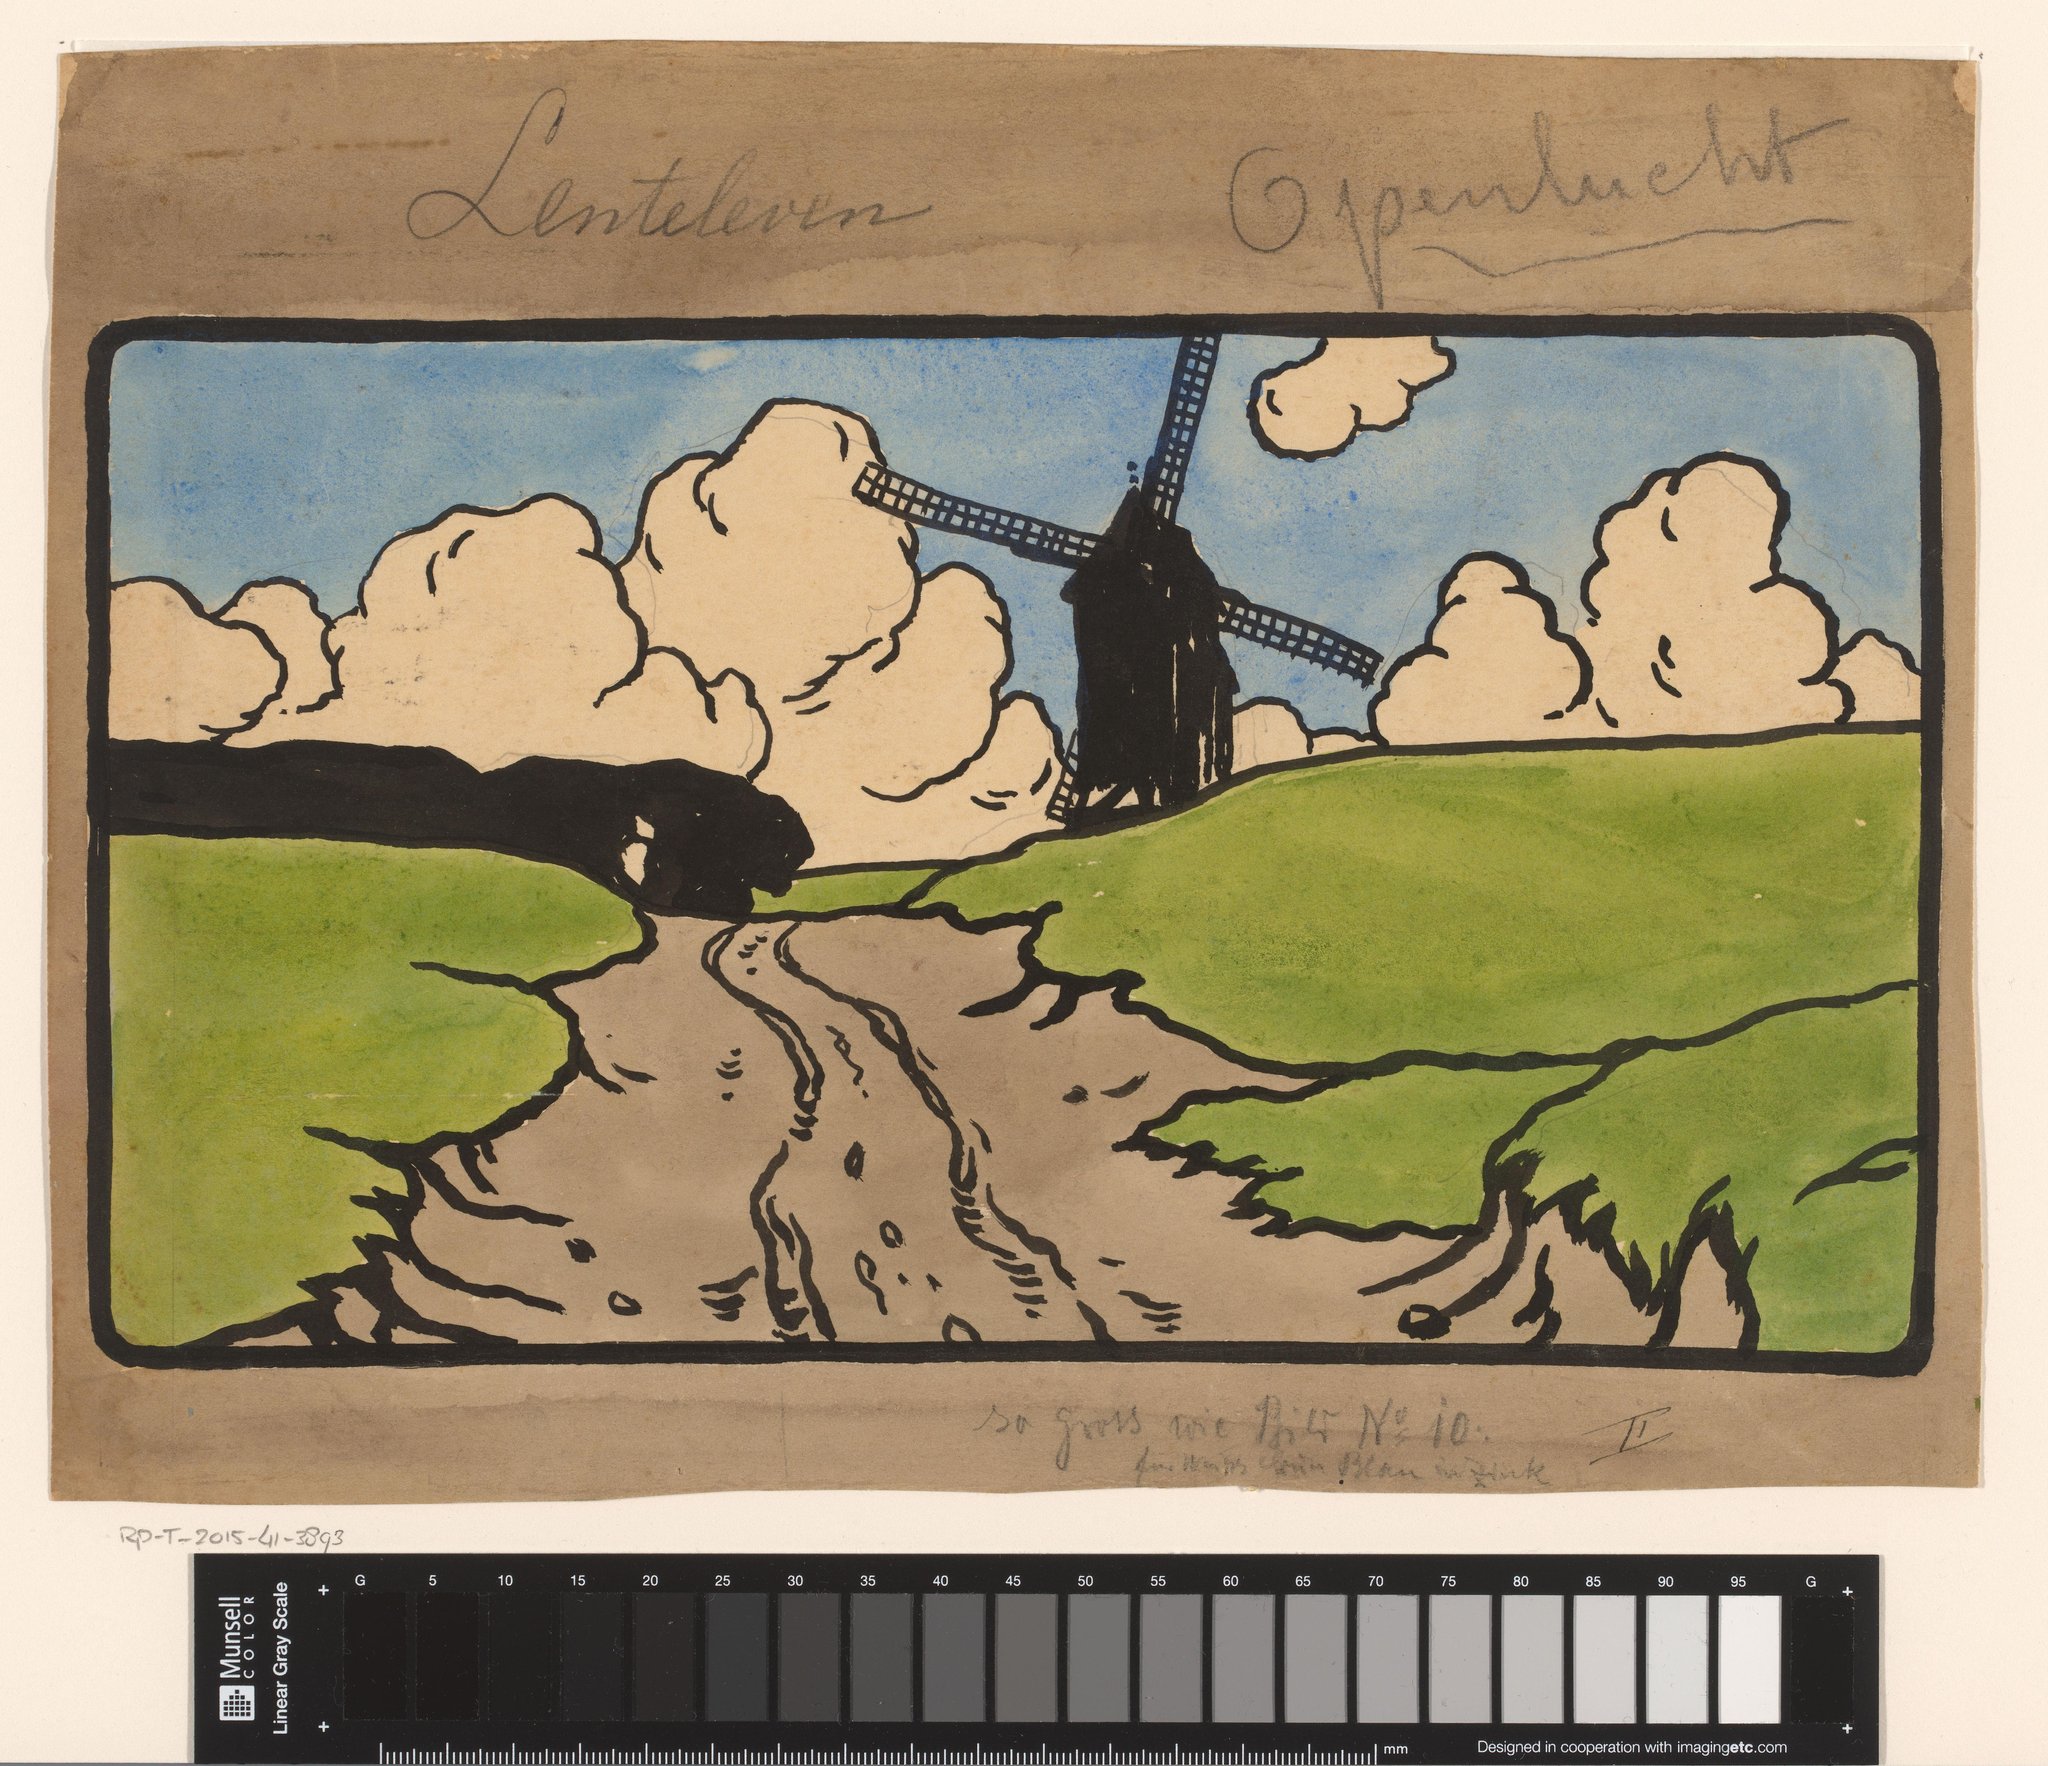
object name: boekillustratie ontwerp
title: Landschap met een molen langs een weg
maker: emmanuel viérin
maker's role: draughtsman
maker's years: 1869-1954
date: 1900-1920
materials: ink, paper, pencil, watercolor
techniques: brush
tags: windmill in landscape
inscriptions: number: ‘II’, annotation: ‘Lenteleven Openlucht’, number: ‘4’, :, collector's mark: Lugt 2228a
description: Vermoedelijk een ontwerp voor: Streuvels, Stijn. Lenteleven. Amsterdam: Veen, 1900 of Streuvels, Stijn. Open lucht. Amsterdam: Veen, [1905-1920].